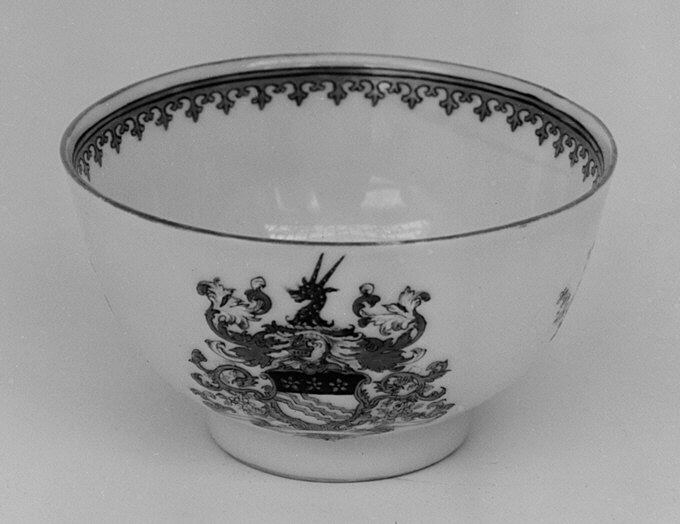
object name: cup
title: Cup (part of a service)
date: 1750-1760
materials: hard paste porcelain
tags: coat of arms